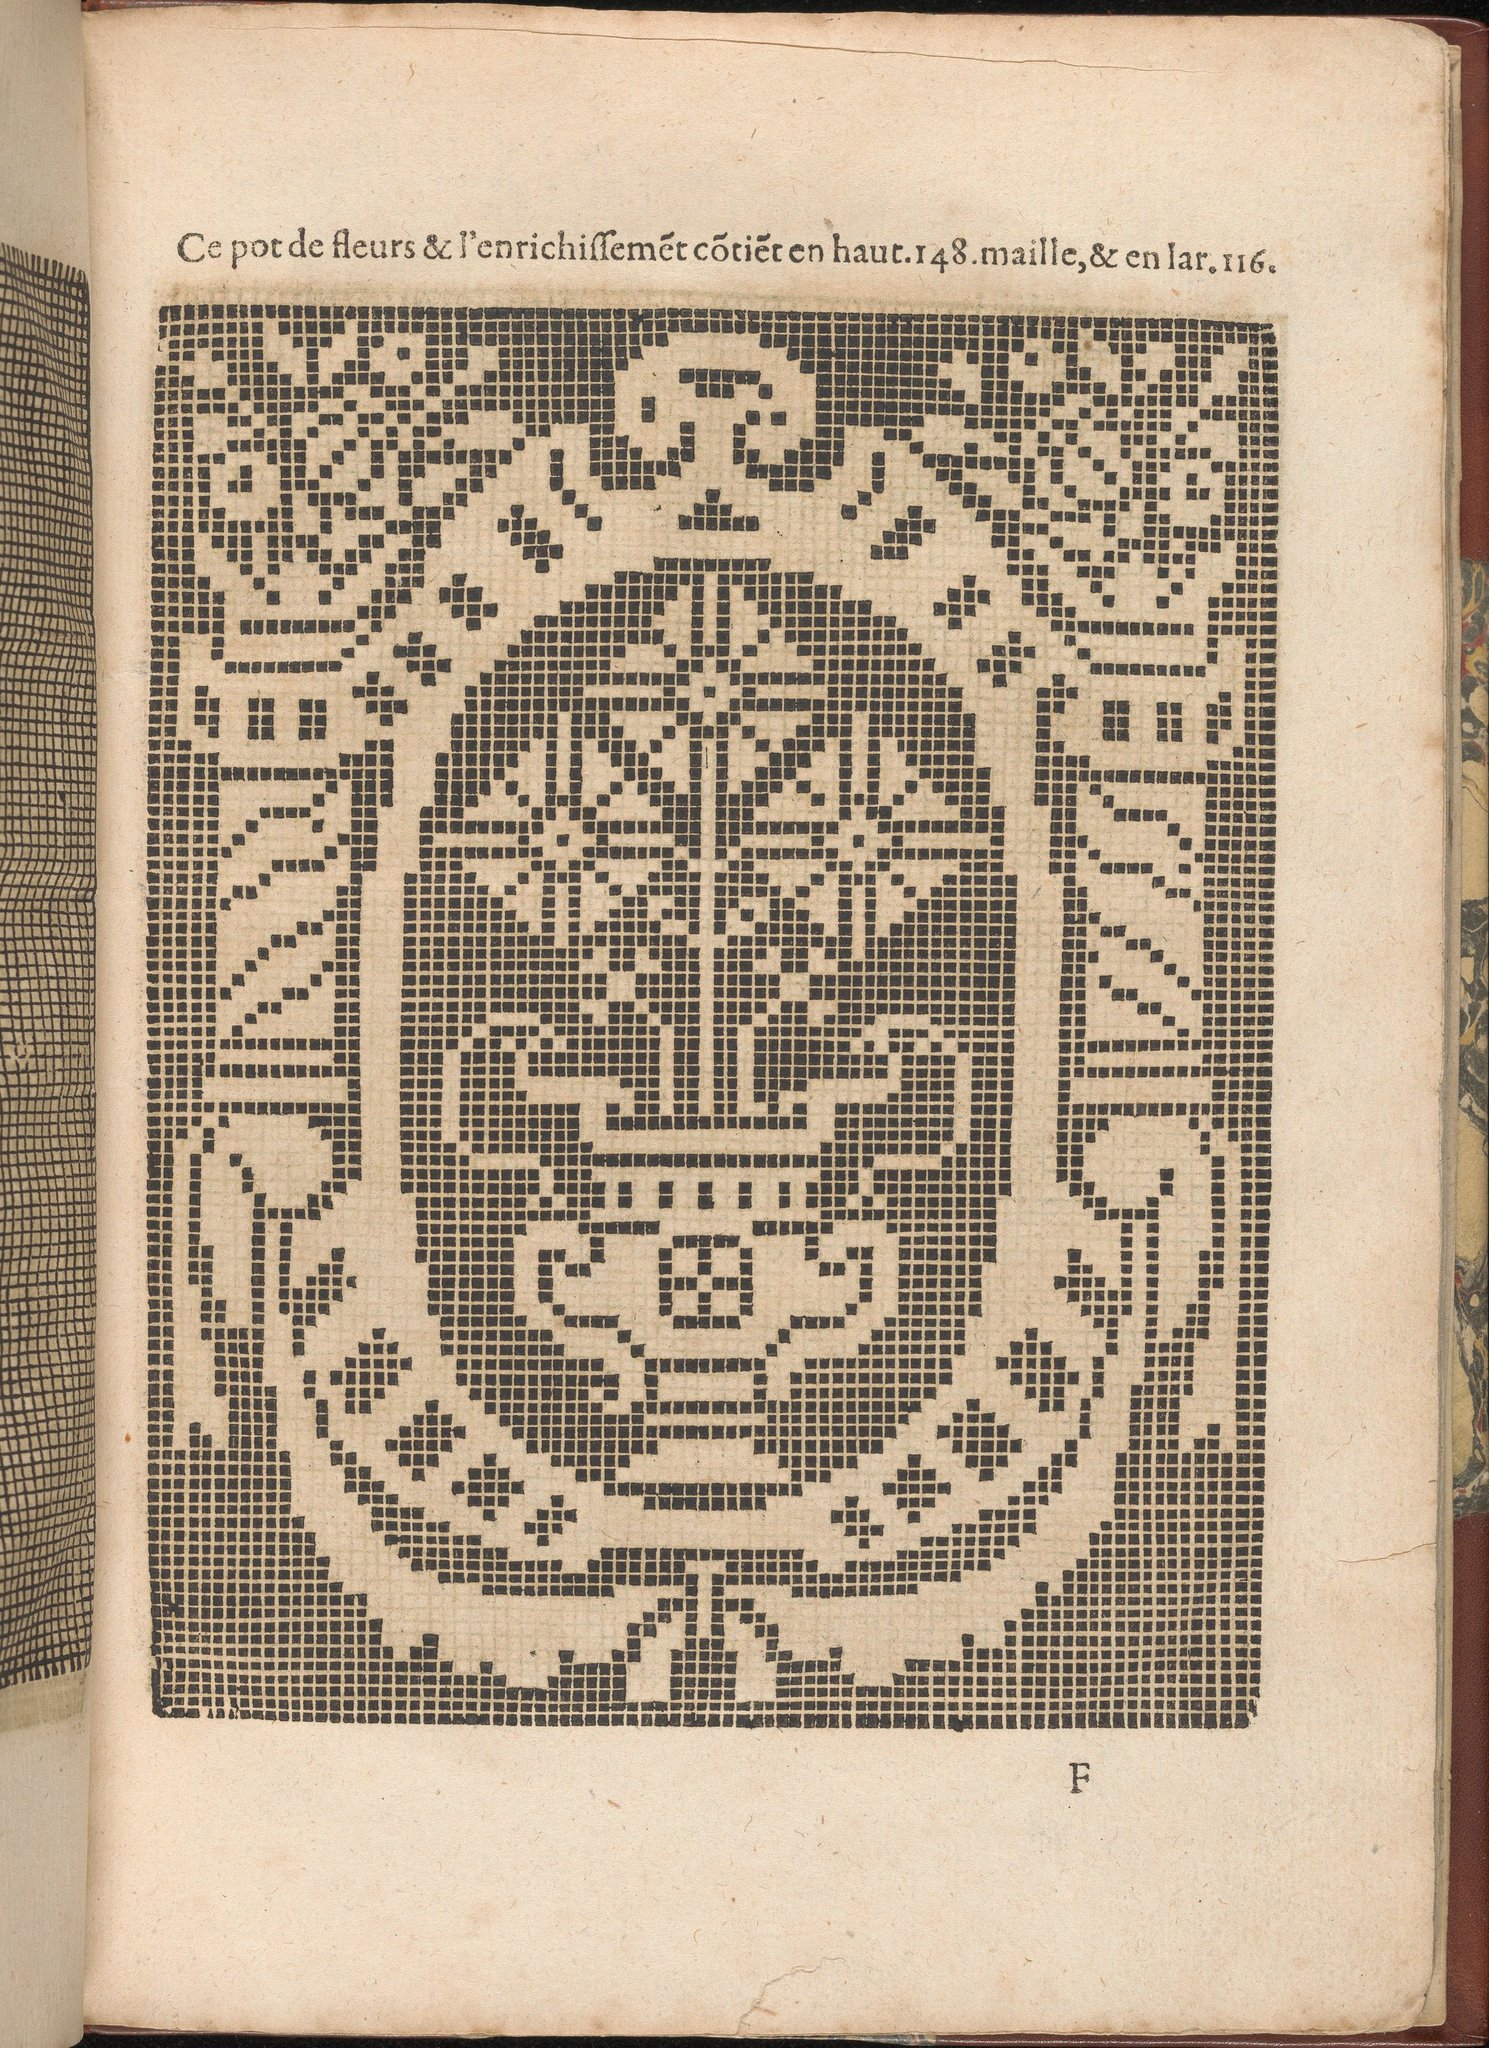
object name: book print ornament architecture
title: Les Secondes Oeuvres, et Subtiles Inventions De Lingerie du Seigneur Federic de Vinciolo Venitien, page 21 (recto)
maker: federico de vinciolo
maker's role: designer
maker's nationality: italian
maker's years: 1582-1599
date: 1603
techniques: woodcut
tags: flowers